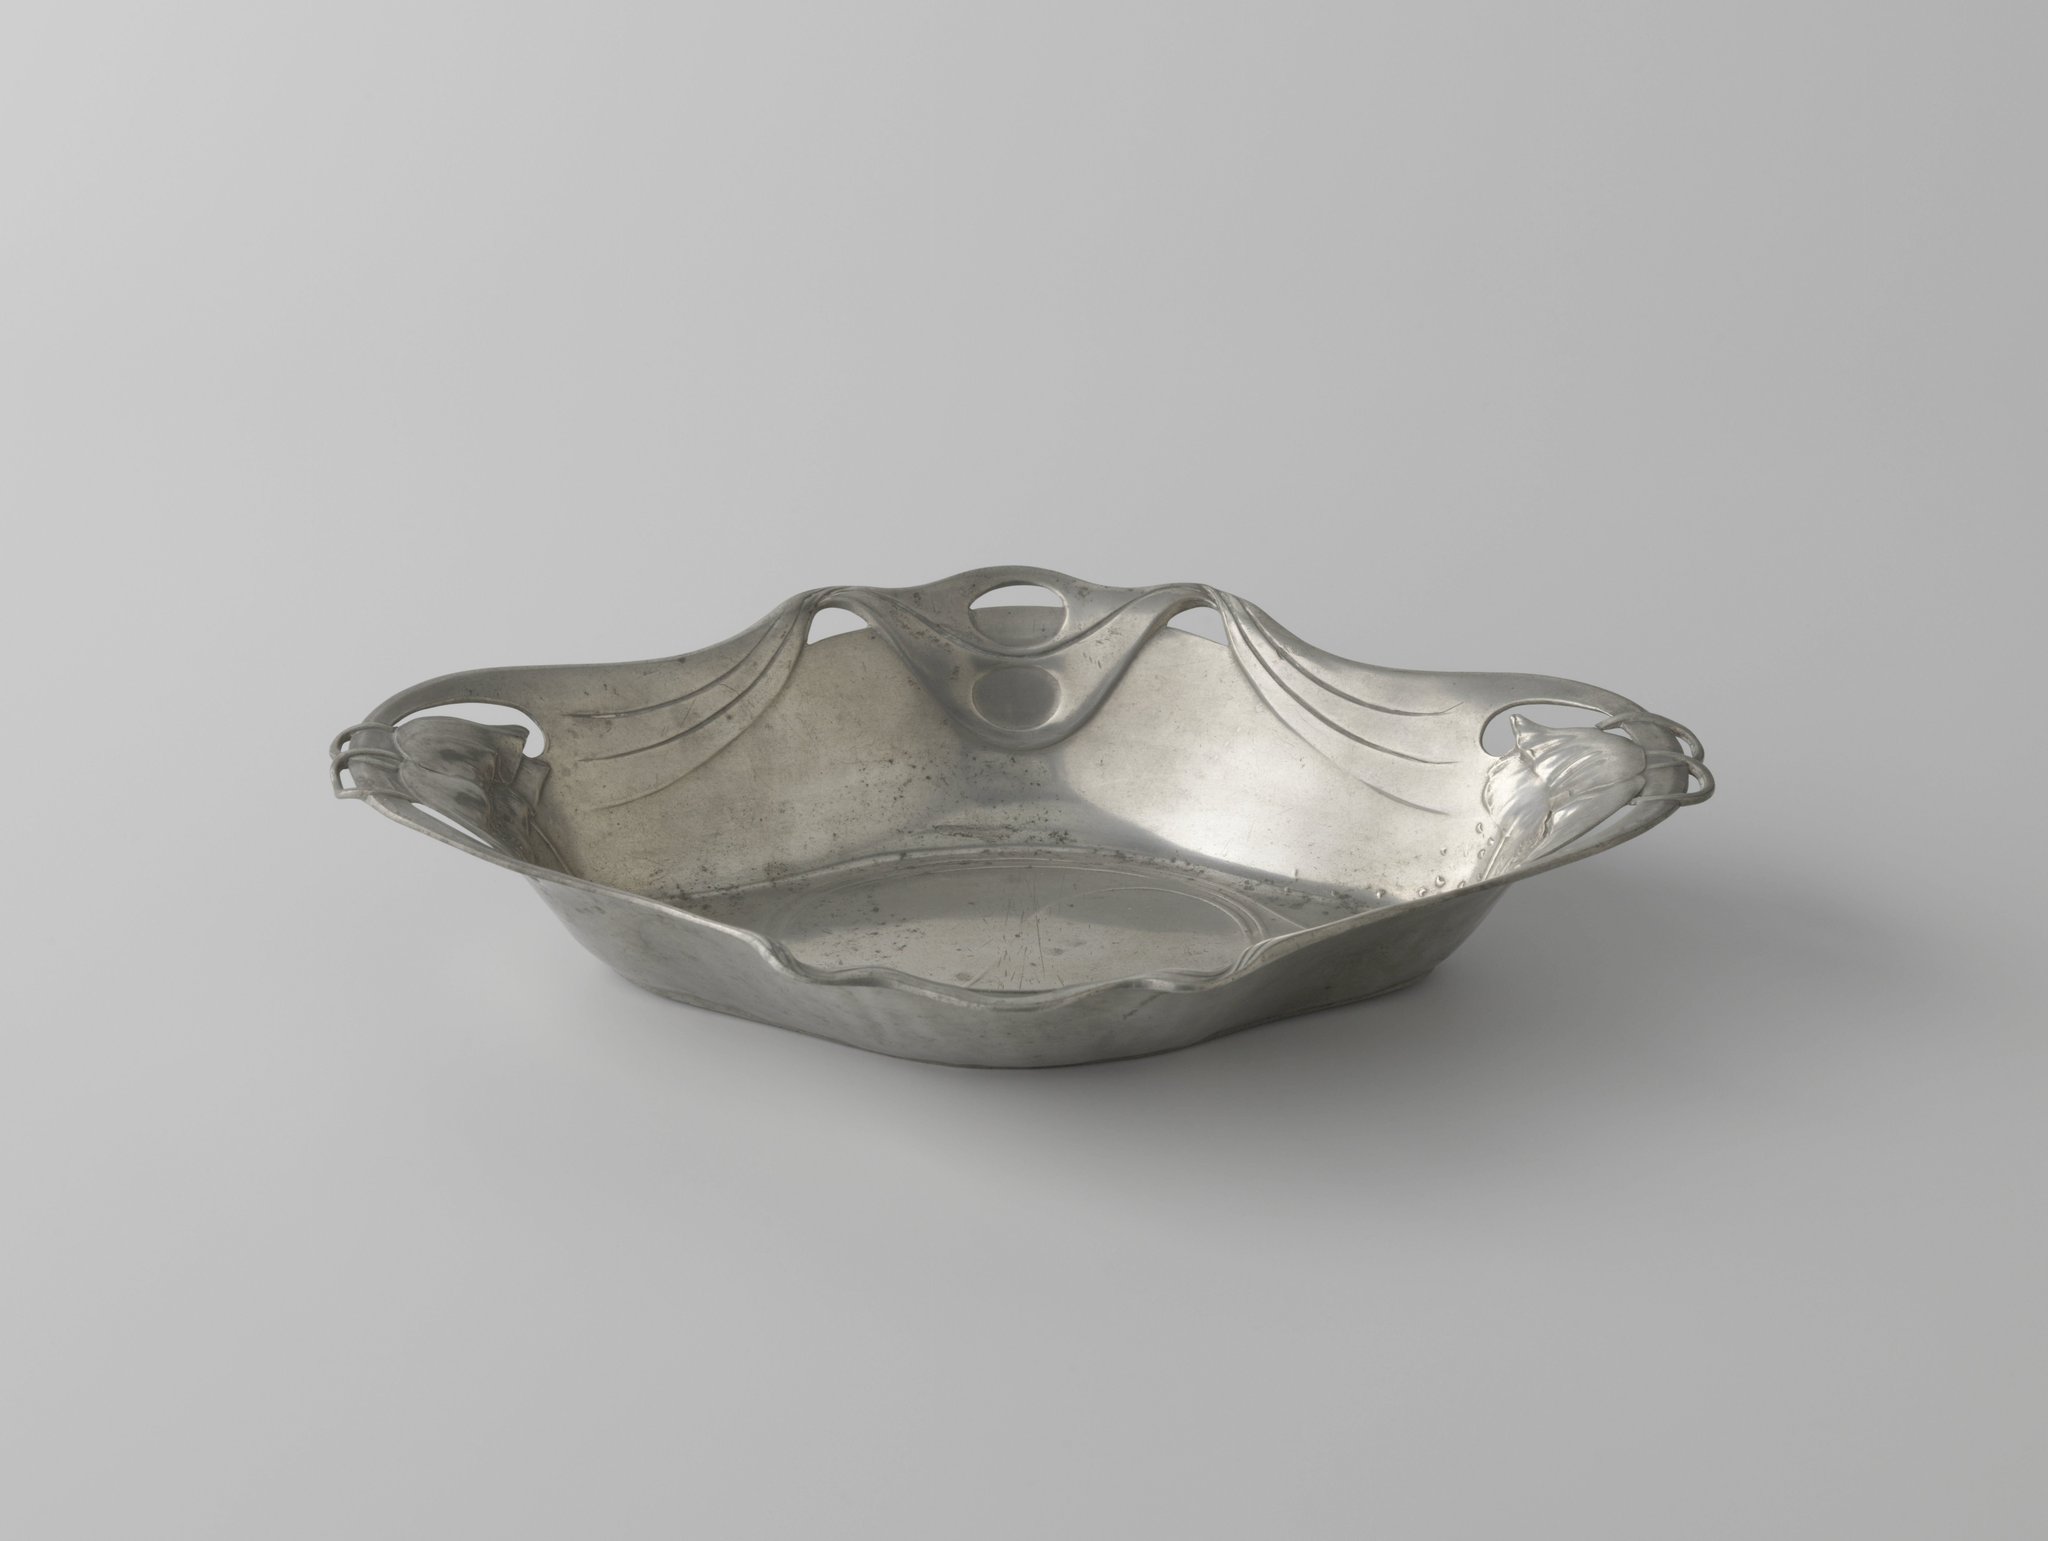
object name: salver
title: Presenteerschaal van tin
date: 1910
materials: tin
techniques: casting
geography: germany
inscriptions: factory mark: ‘X "ORIVIT" 2178’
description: Presenteerschaal van tin, Jugendstil. De ovale schaal heeft een hoge, schuin naar buiten uitlopende opstaande rand. Deze is versierd met bloemmotieven, waarvan de stelen doorlopen tot op de bodem en daar een geprofileerde band vormen. Aan de lange zijden van de rand zijn sierlijke banen, die doen denken aan het doek van een toneeldecor.